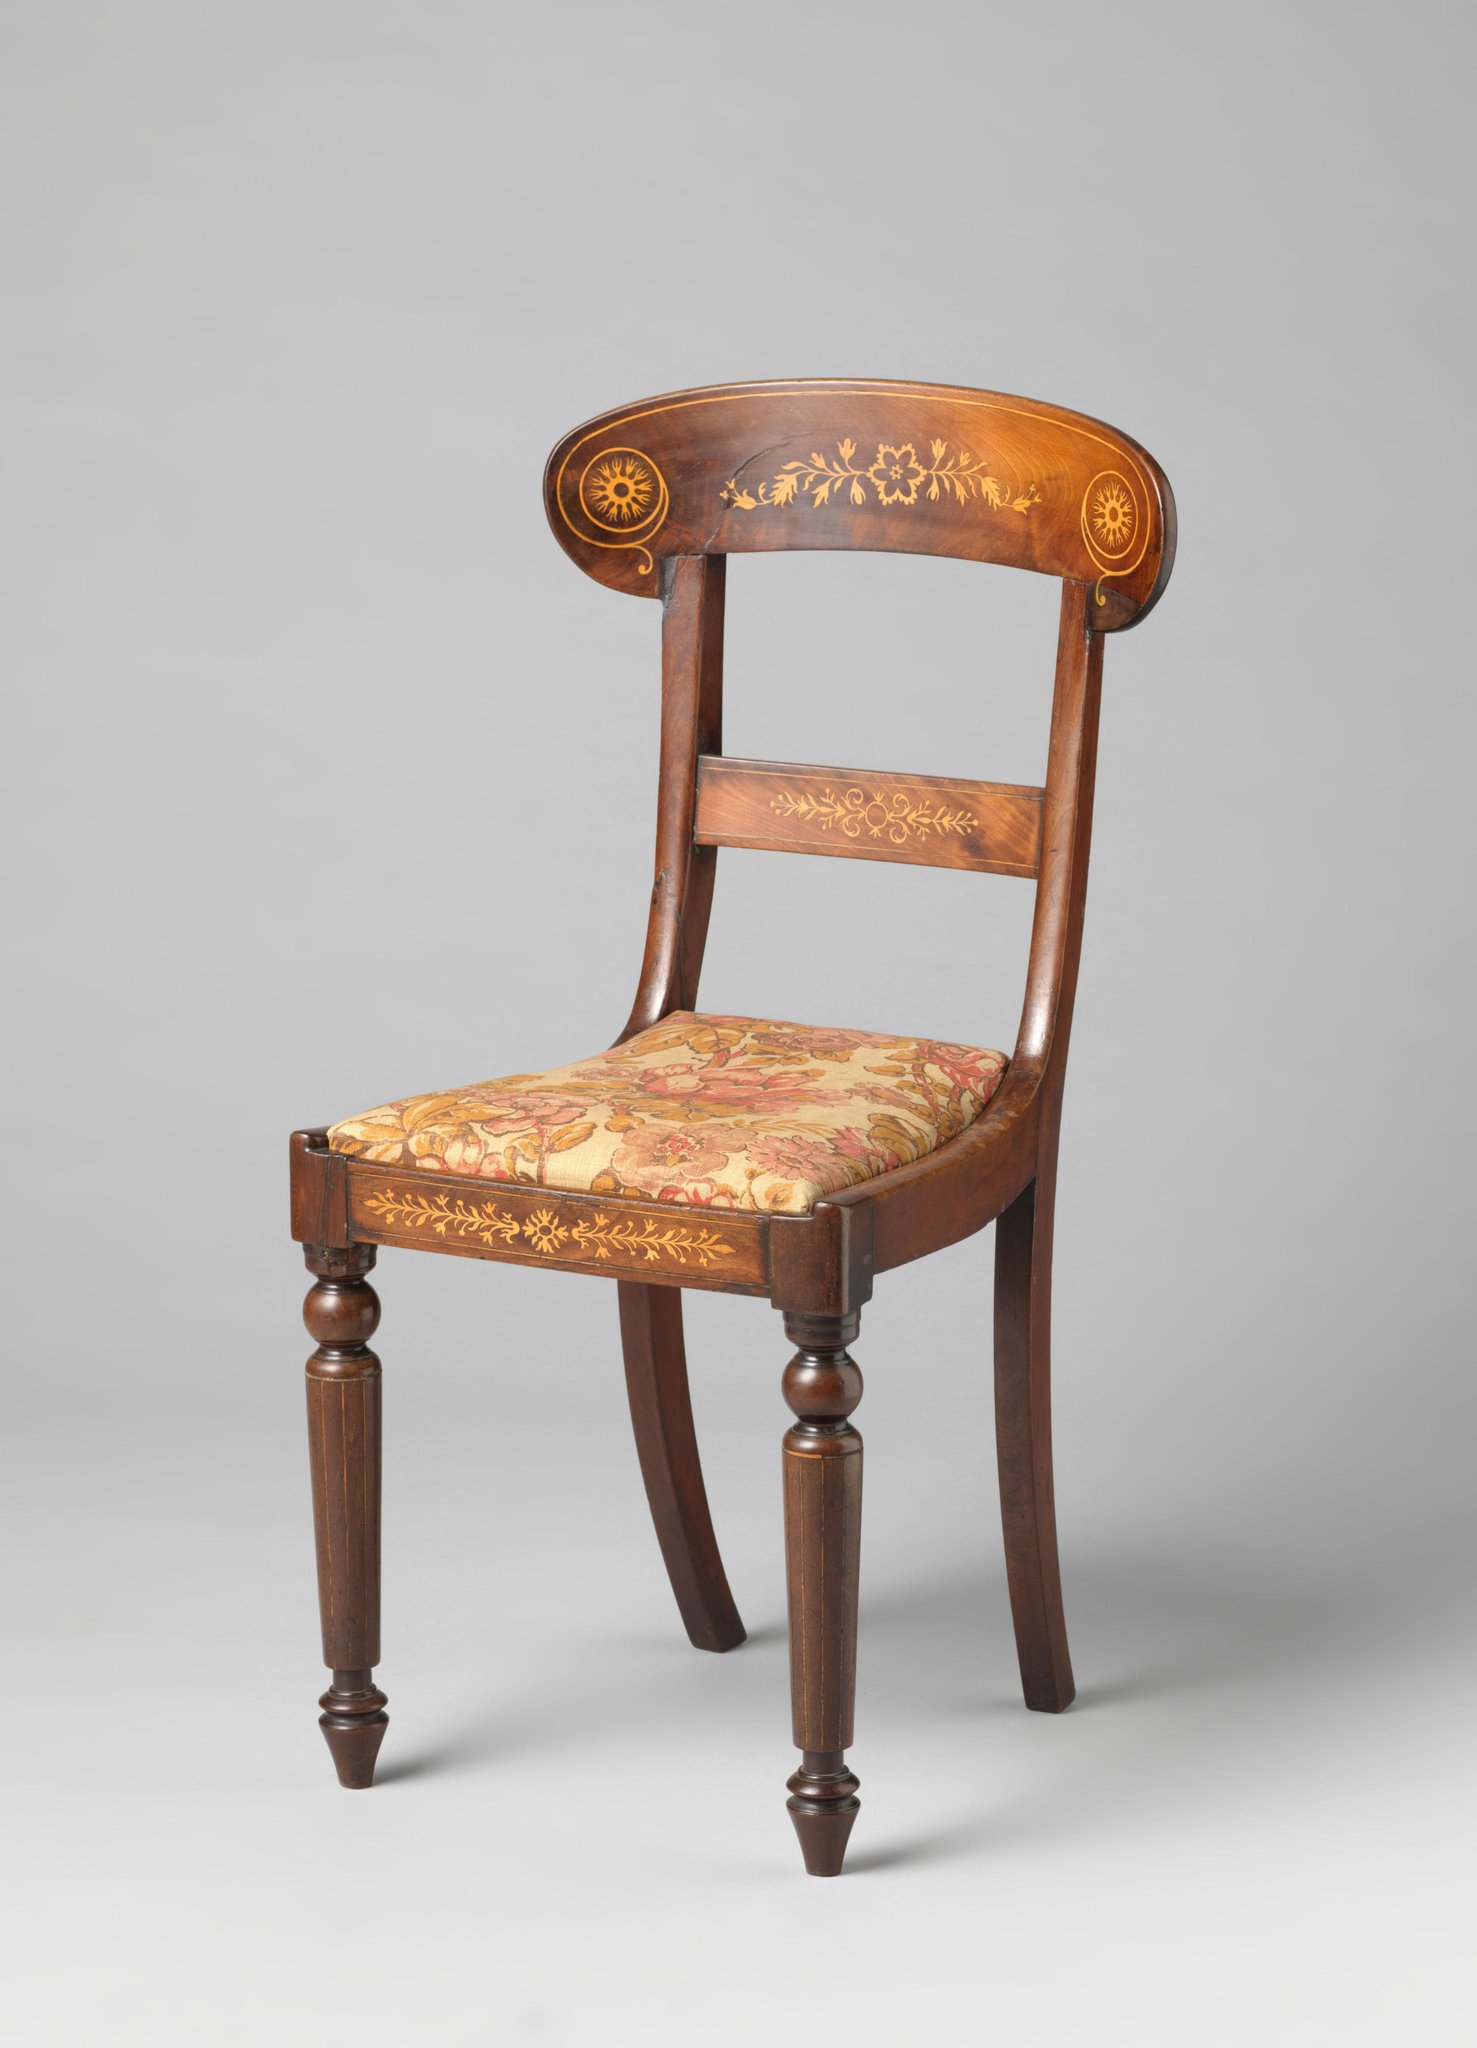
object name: seating furniture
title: Stoel van mahoniehout, versierd met marqueterie van essenhout, voorzitregel en rugsporten hebben gestileerde blad- en bloemmotieven, losse beklede zitting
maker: Anonymous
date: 1820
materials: cotton, wood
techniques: marquetry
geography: northern netherlands